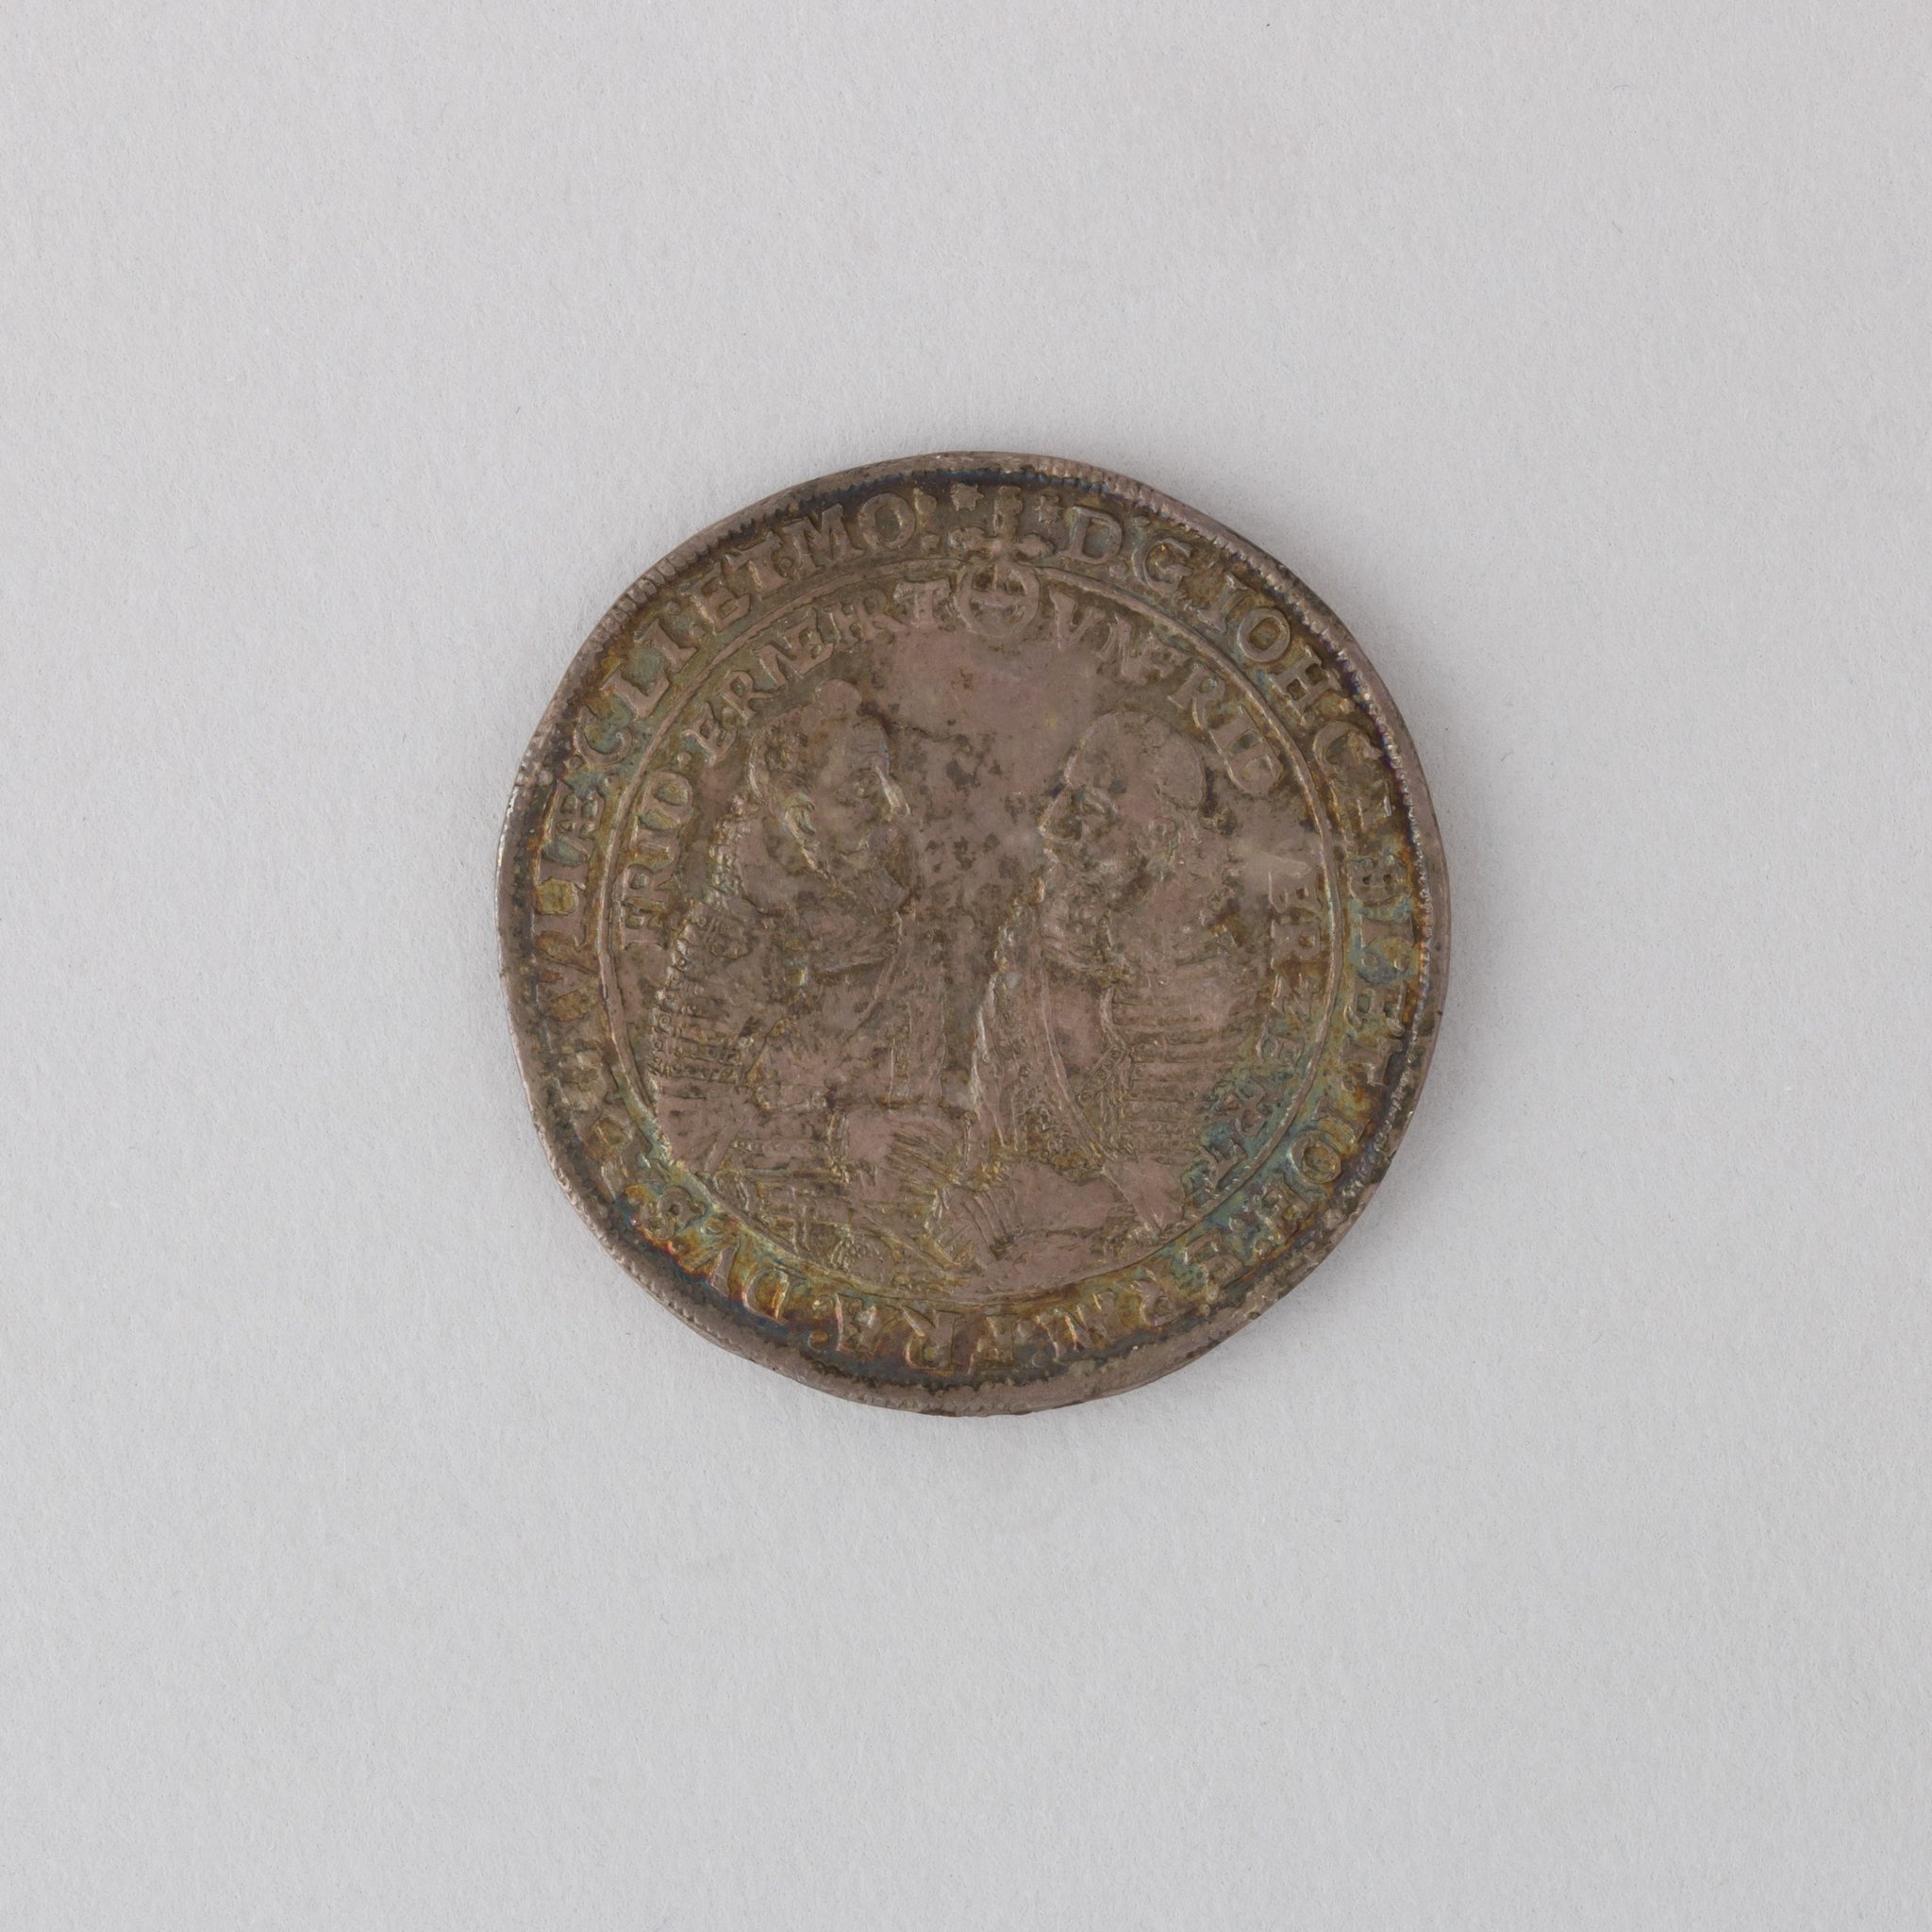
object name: coin thaler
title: Coin (Thaler) Showing John Casimir and John Ernest, Dukes of Saxony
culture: german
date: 1616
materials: silver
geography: germany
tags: coins